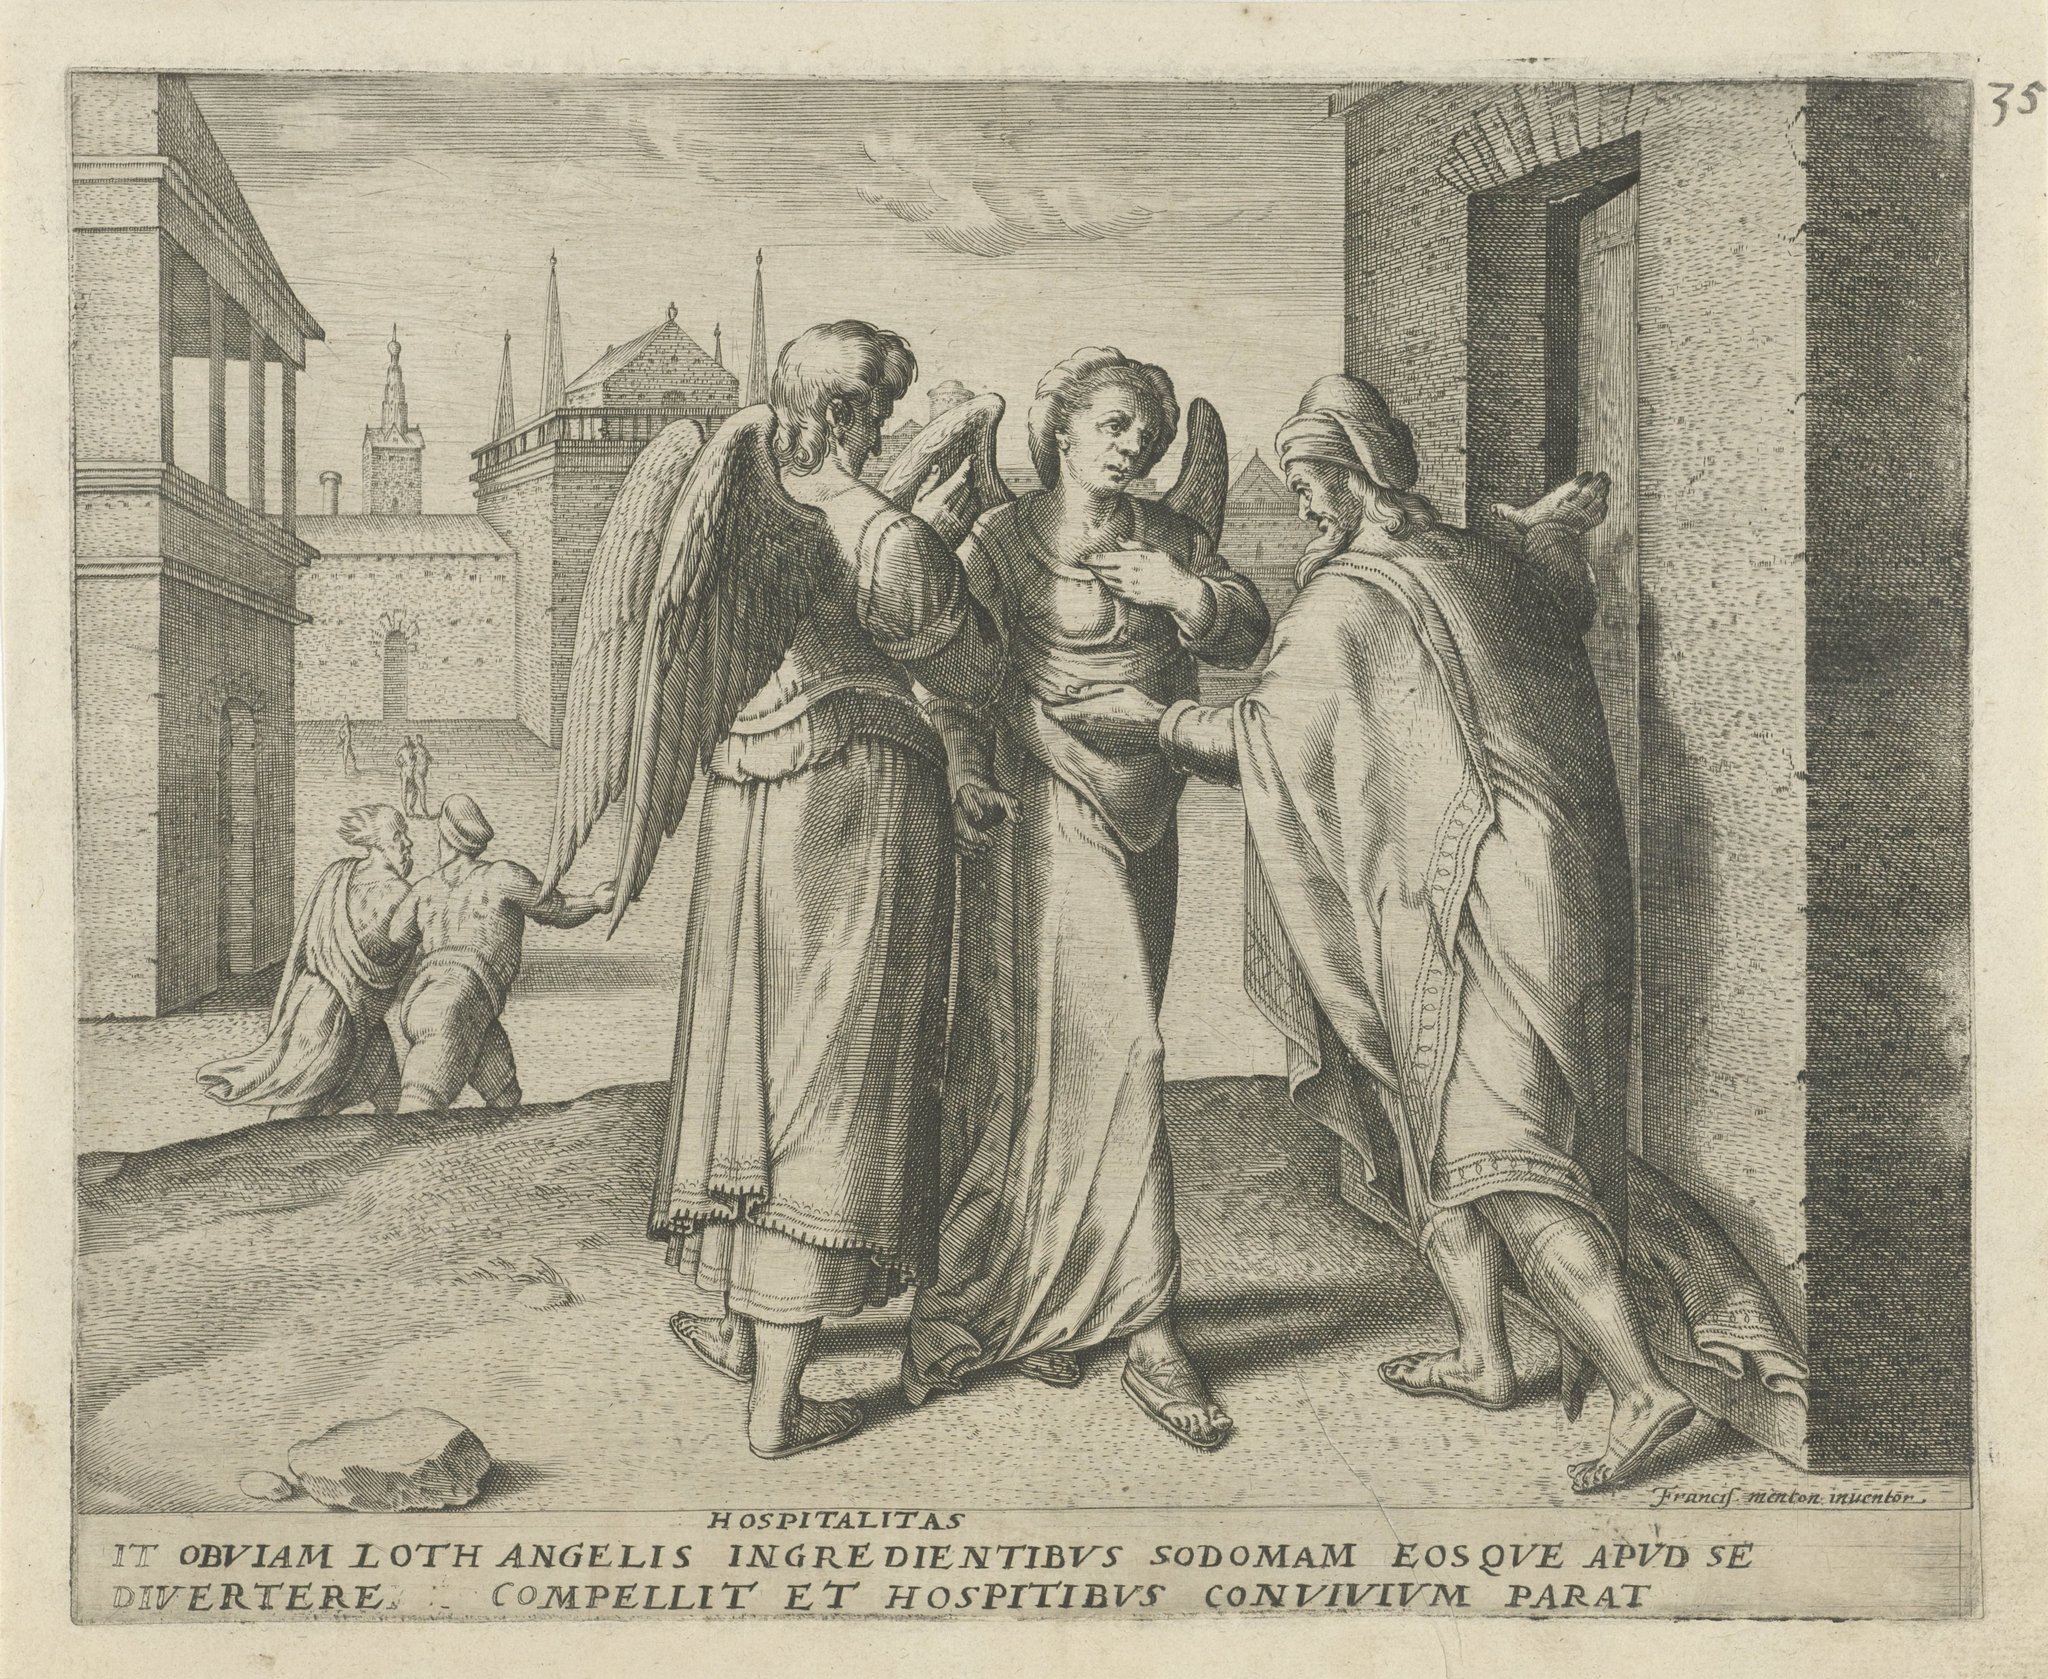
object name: print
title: Lot en de twee engelen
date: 1550-1570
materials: paper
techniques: engraving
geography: netherlands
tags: lot and the two angels (genesis 19:1-23)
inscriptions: collector's mark: Lugt 2228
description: Dit is de eerste staat van twee van de eerste editie van deze prent, die mogelijk door Hieronymus Cock werd uitgegeven. De plaat kwam, vermoedelijk na de dood van Cock, in handen van Gerard de Jode. De voorstelling van de plaat werd toen compleet verwijderd en er kwam een iets andere compositie voor in de plaats. Alleen de tekst bleef ongewijzigd. De plaat werd vervolgens gebruikt in: Thesaurus sacrarum historiaru veteris testamenti, elegatissimis imaginibus expressu excelletissimoru in hac arte viroru opera : nuc primu in luce editus. Antwerpen: Gerard de Jode, 1579. Van die tweede editie, toegeschreven aan Hans Collaert (I), bestaan drie staten.